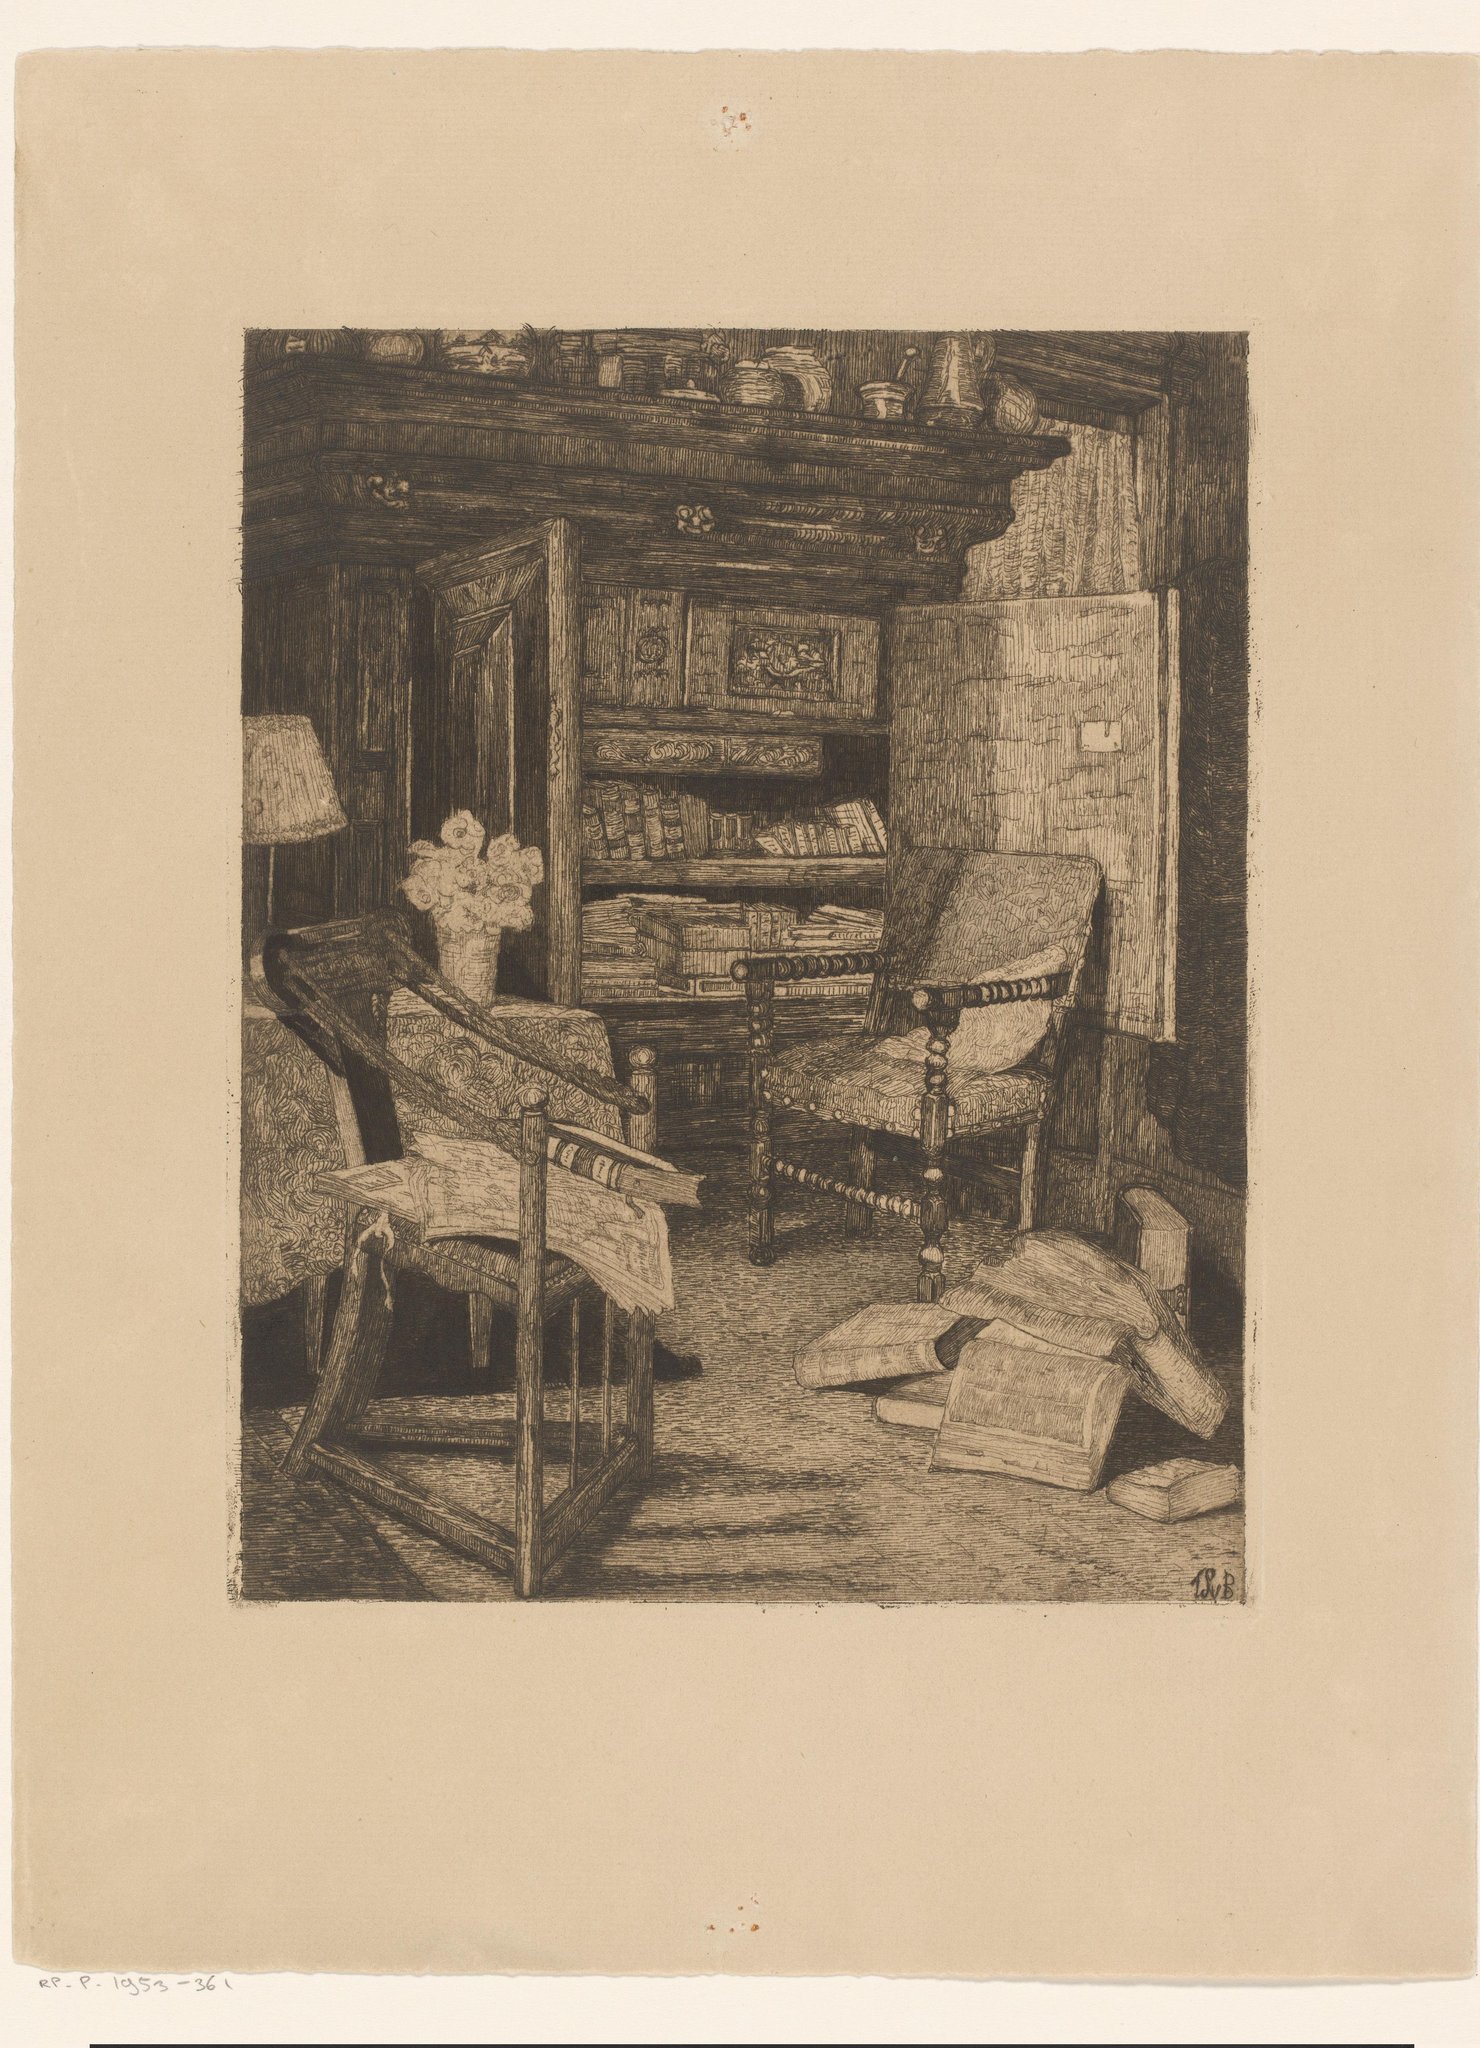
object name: print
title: Oud-Hollandse kast met boeken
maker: theodora jacoba van bosse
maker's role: print maker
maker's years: 1874-1953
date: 1899-1953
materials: paper, ink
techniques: aquatint, drypoint, etching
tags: bookcase, with doors, interior of the house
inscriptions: collector's mark: Lugt 2228, monogram: ‘TJvB’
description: Interieur met een boekenkast, twee stoelen en links een tafel. Op de linker stoel en op de grond liggen boeken.